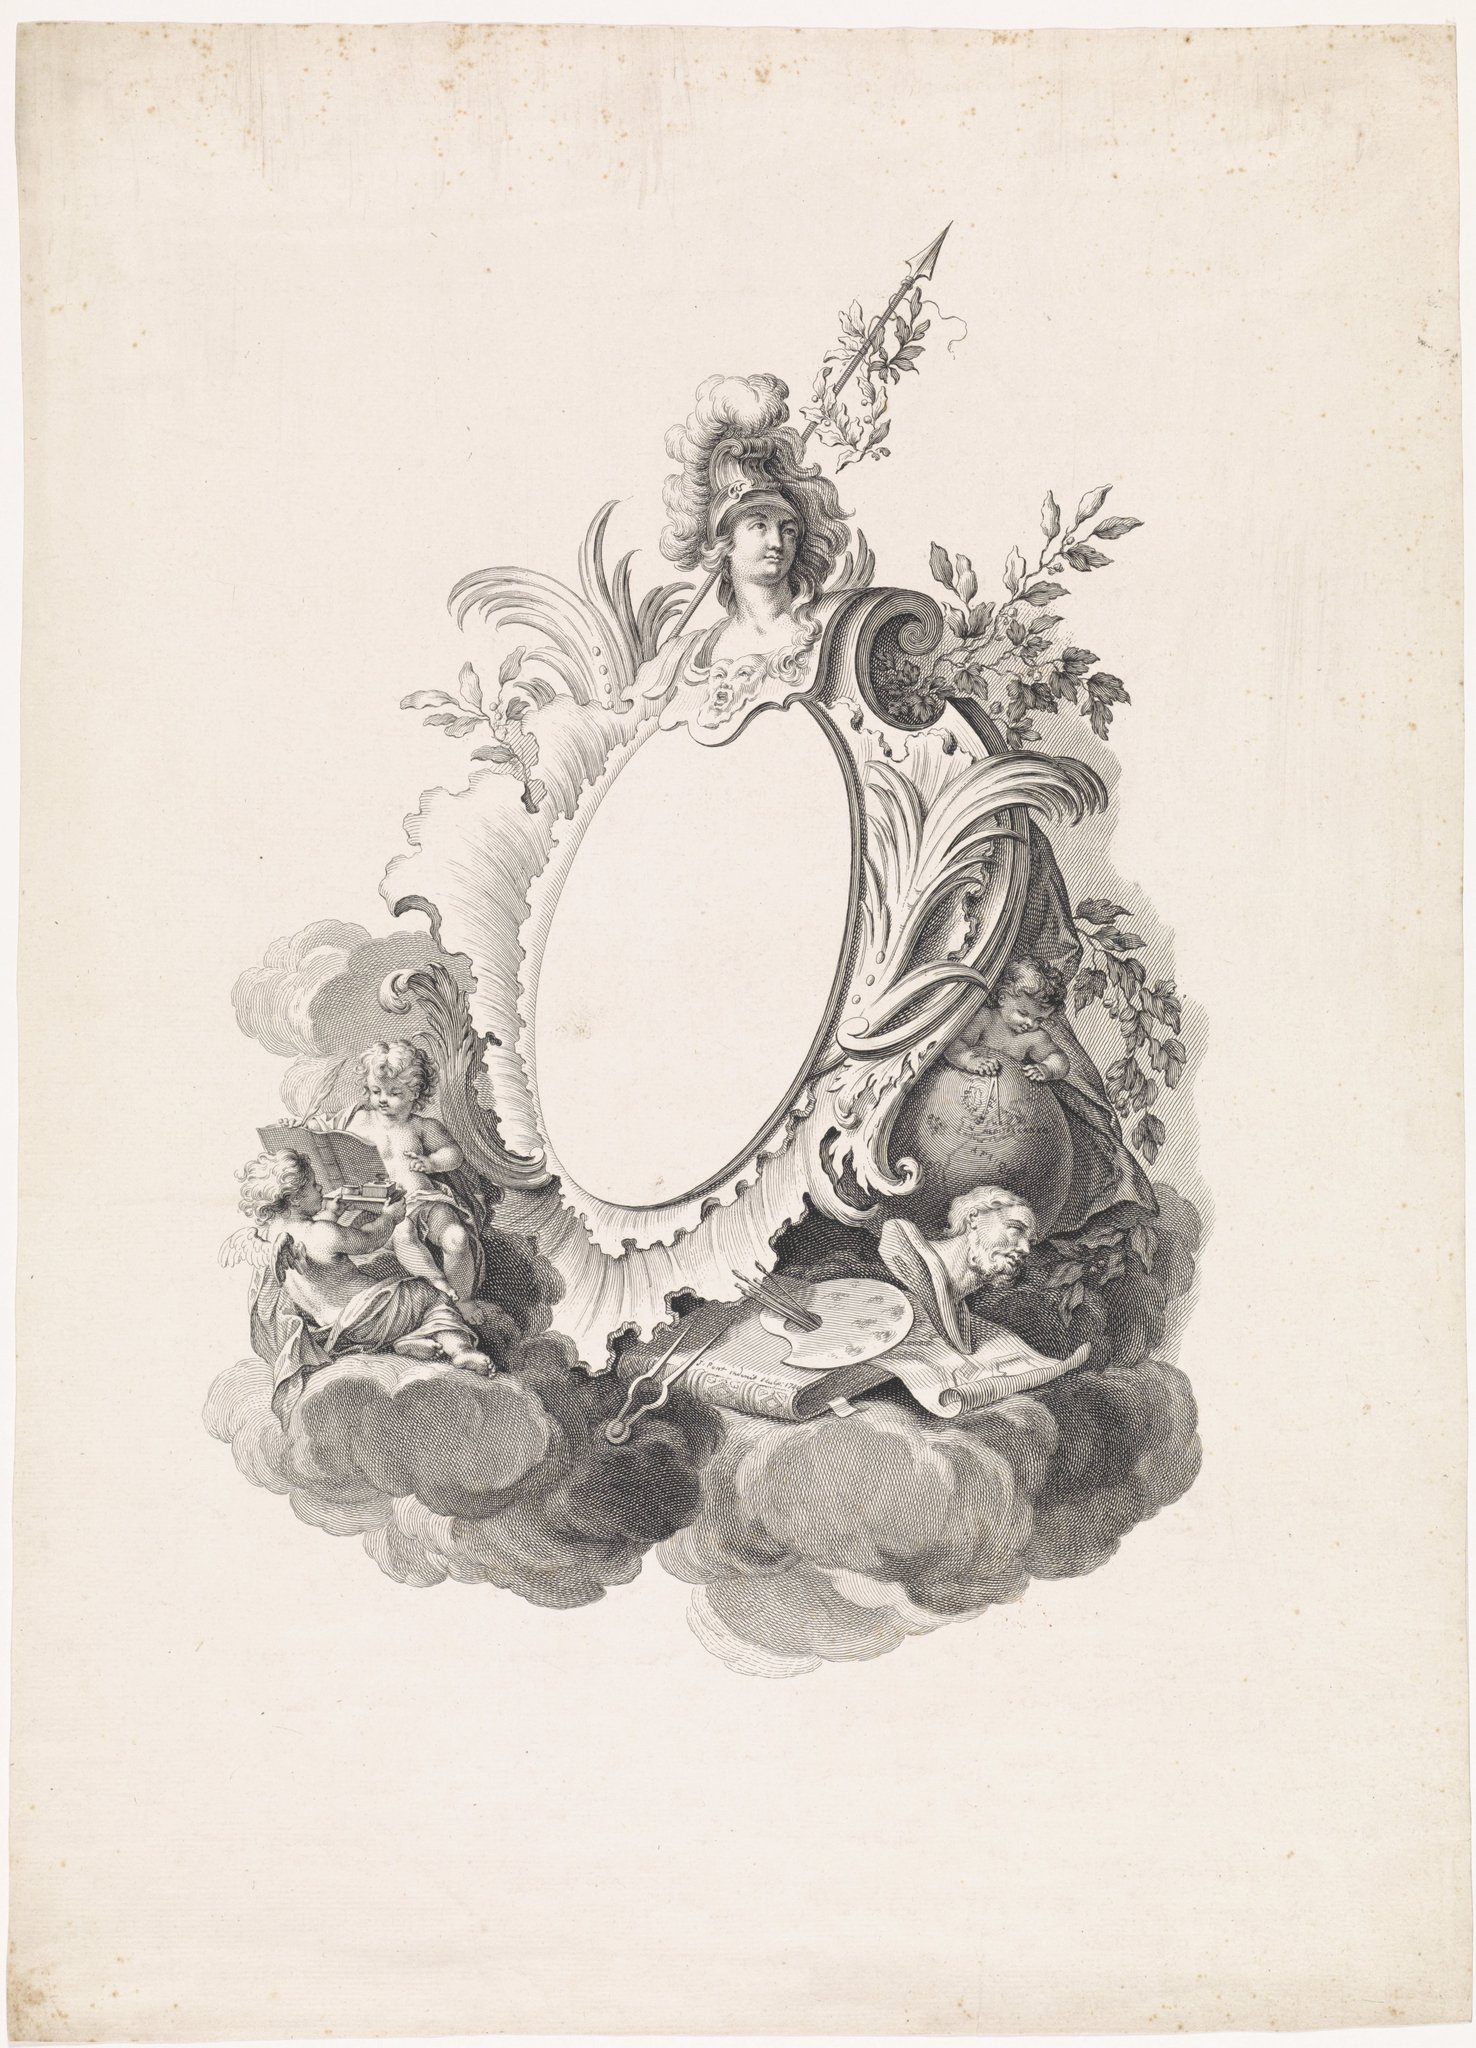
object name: print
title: Leeg cartouche bekroond met buste van Minerva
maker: jan punt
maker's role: draughtsman, print maker, publisher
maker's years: 1711-1779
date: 1740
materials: paper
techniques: engraving, etching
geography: amsterdam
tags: (story of) minerva (pallas, athena), writing tools, compasses, piece of sculpture, reproduction of a piece of sculpture, palette, globe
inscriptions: inscription: ‘J: Punt invenit sculp: 1740’, collector's mark: Lugt 240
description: Een leeg cartouche bekroond met een buste van Minerva, omringd door olijftakken. De cartouche is omgeven door wolken. Links twee putti, van wie de een in een boek schrijft, en de ander een inktpot ophoudt. Rechts attributen van de kunsten (passer, palet, antieke buste) en een putto die met een passer bij een globe staat.